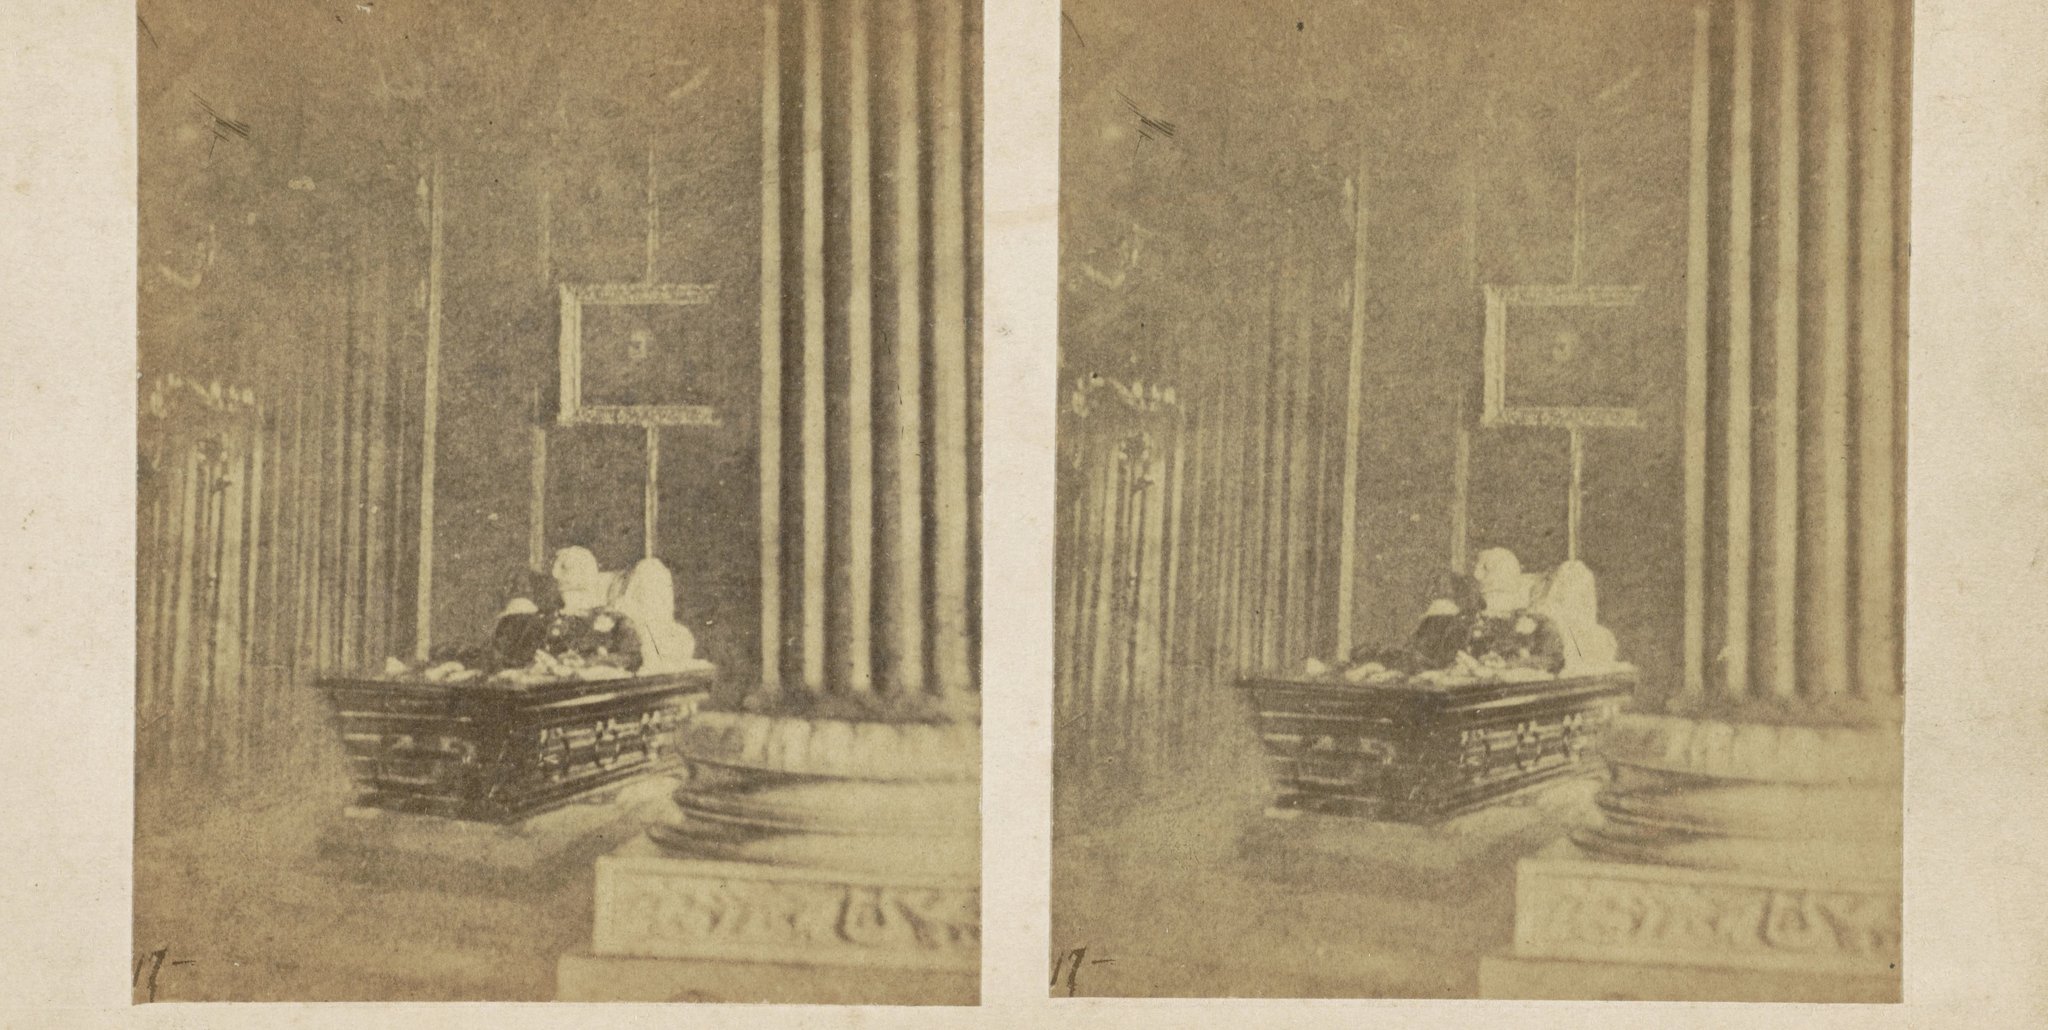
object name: stereograph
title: Baar van Frederik Willem IV van Pruisen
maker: Anonymous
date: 1861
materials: cardboard, paper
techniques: albumen print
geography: potsdam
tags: berlin, frederik willem iv (koning van pruisen), coffin, public funeral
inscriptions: number: ‘17-’